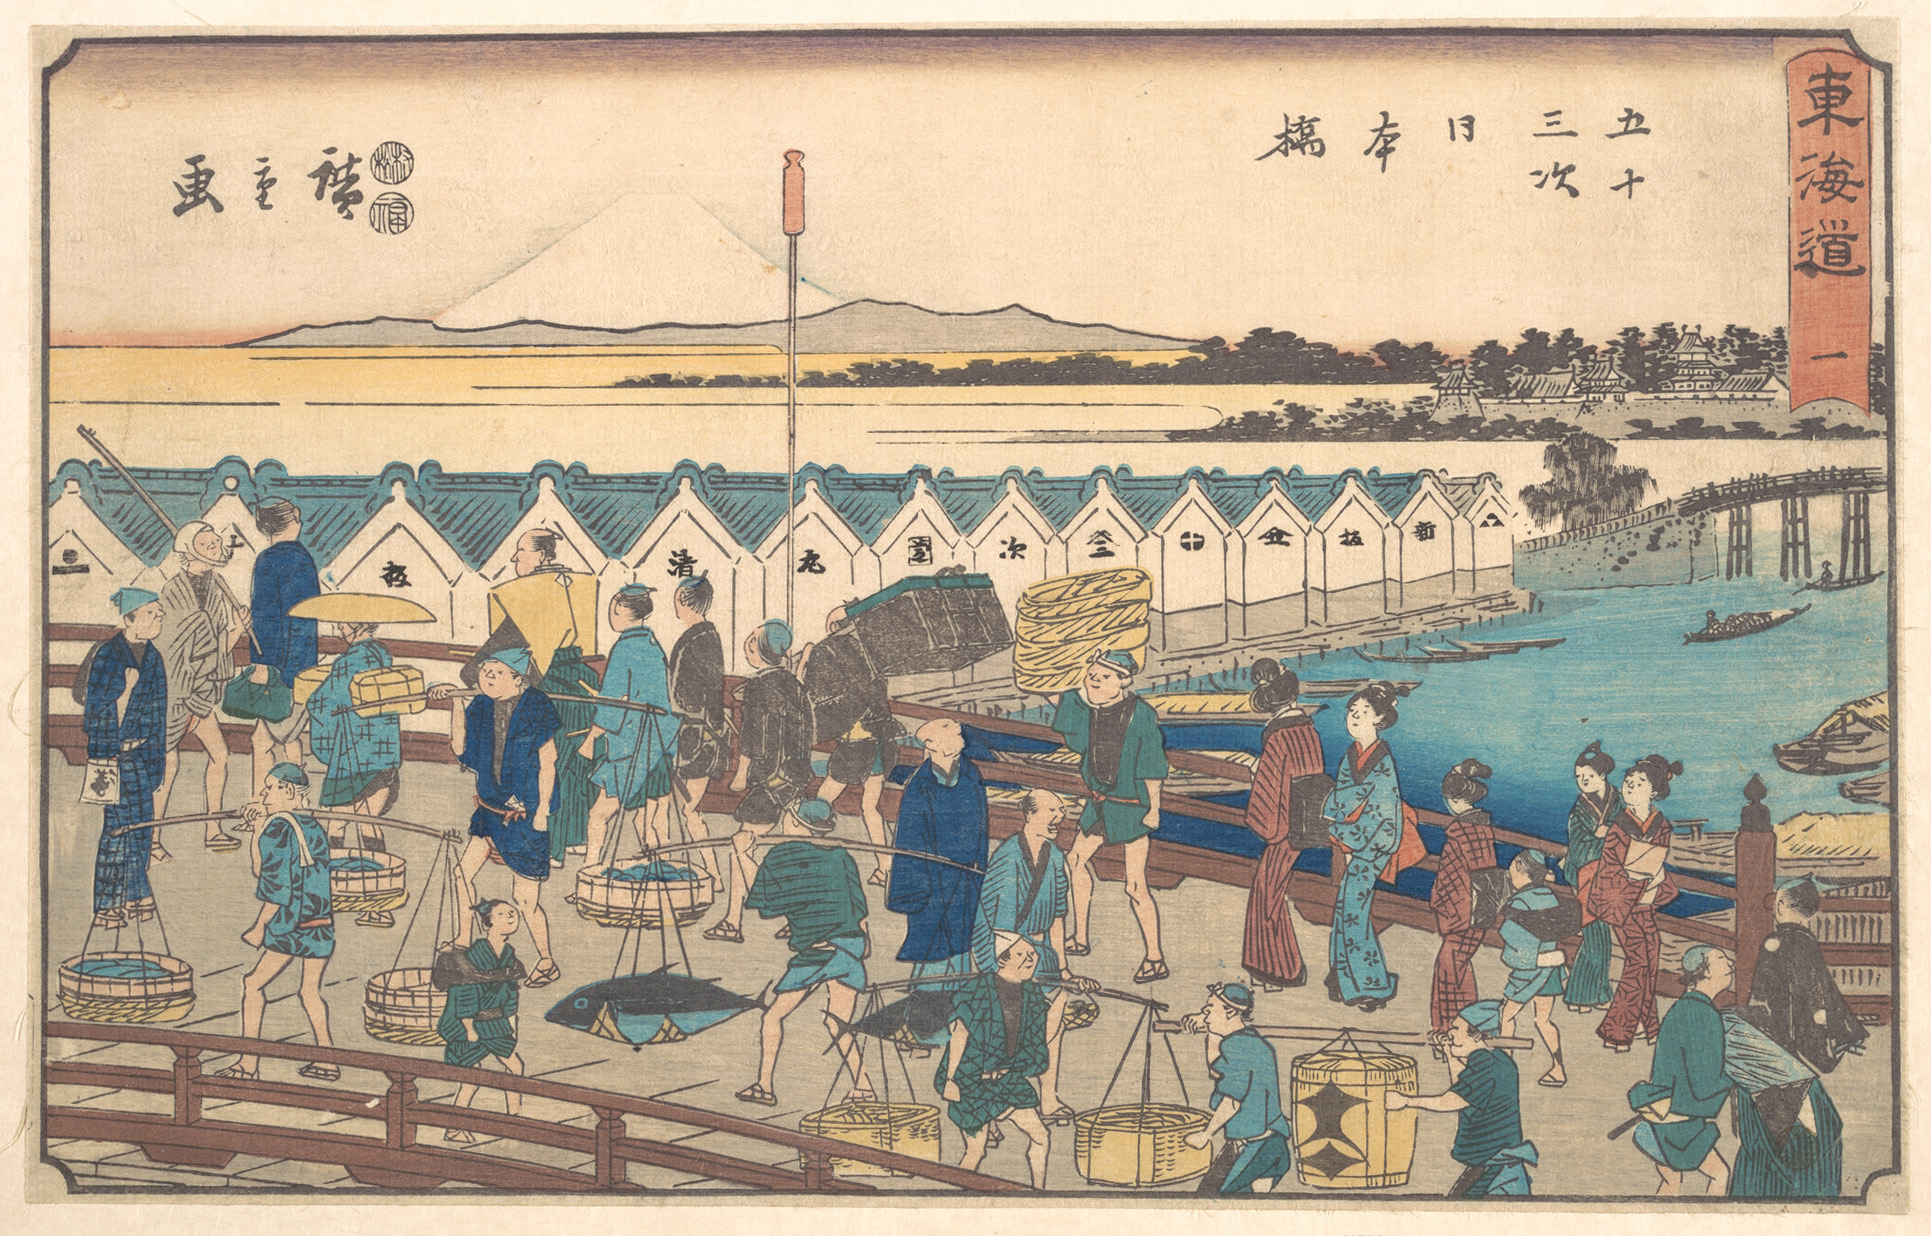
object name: print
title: Nihon bashi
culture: japanese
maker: utagawa hiroshige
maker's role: artist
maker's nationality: japanese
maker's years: 1797-1858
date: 1848-1849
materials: ink, paper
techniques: woodblock print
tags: bridges,fish,crowd,daily life